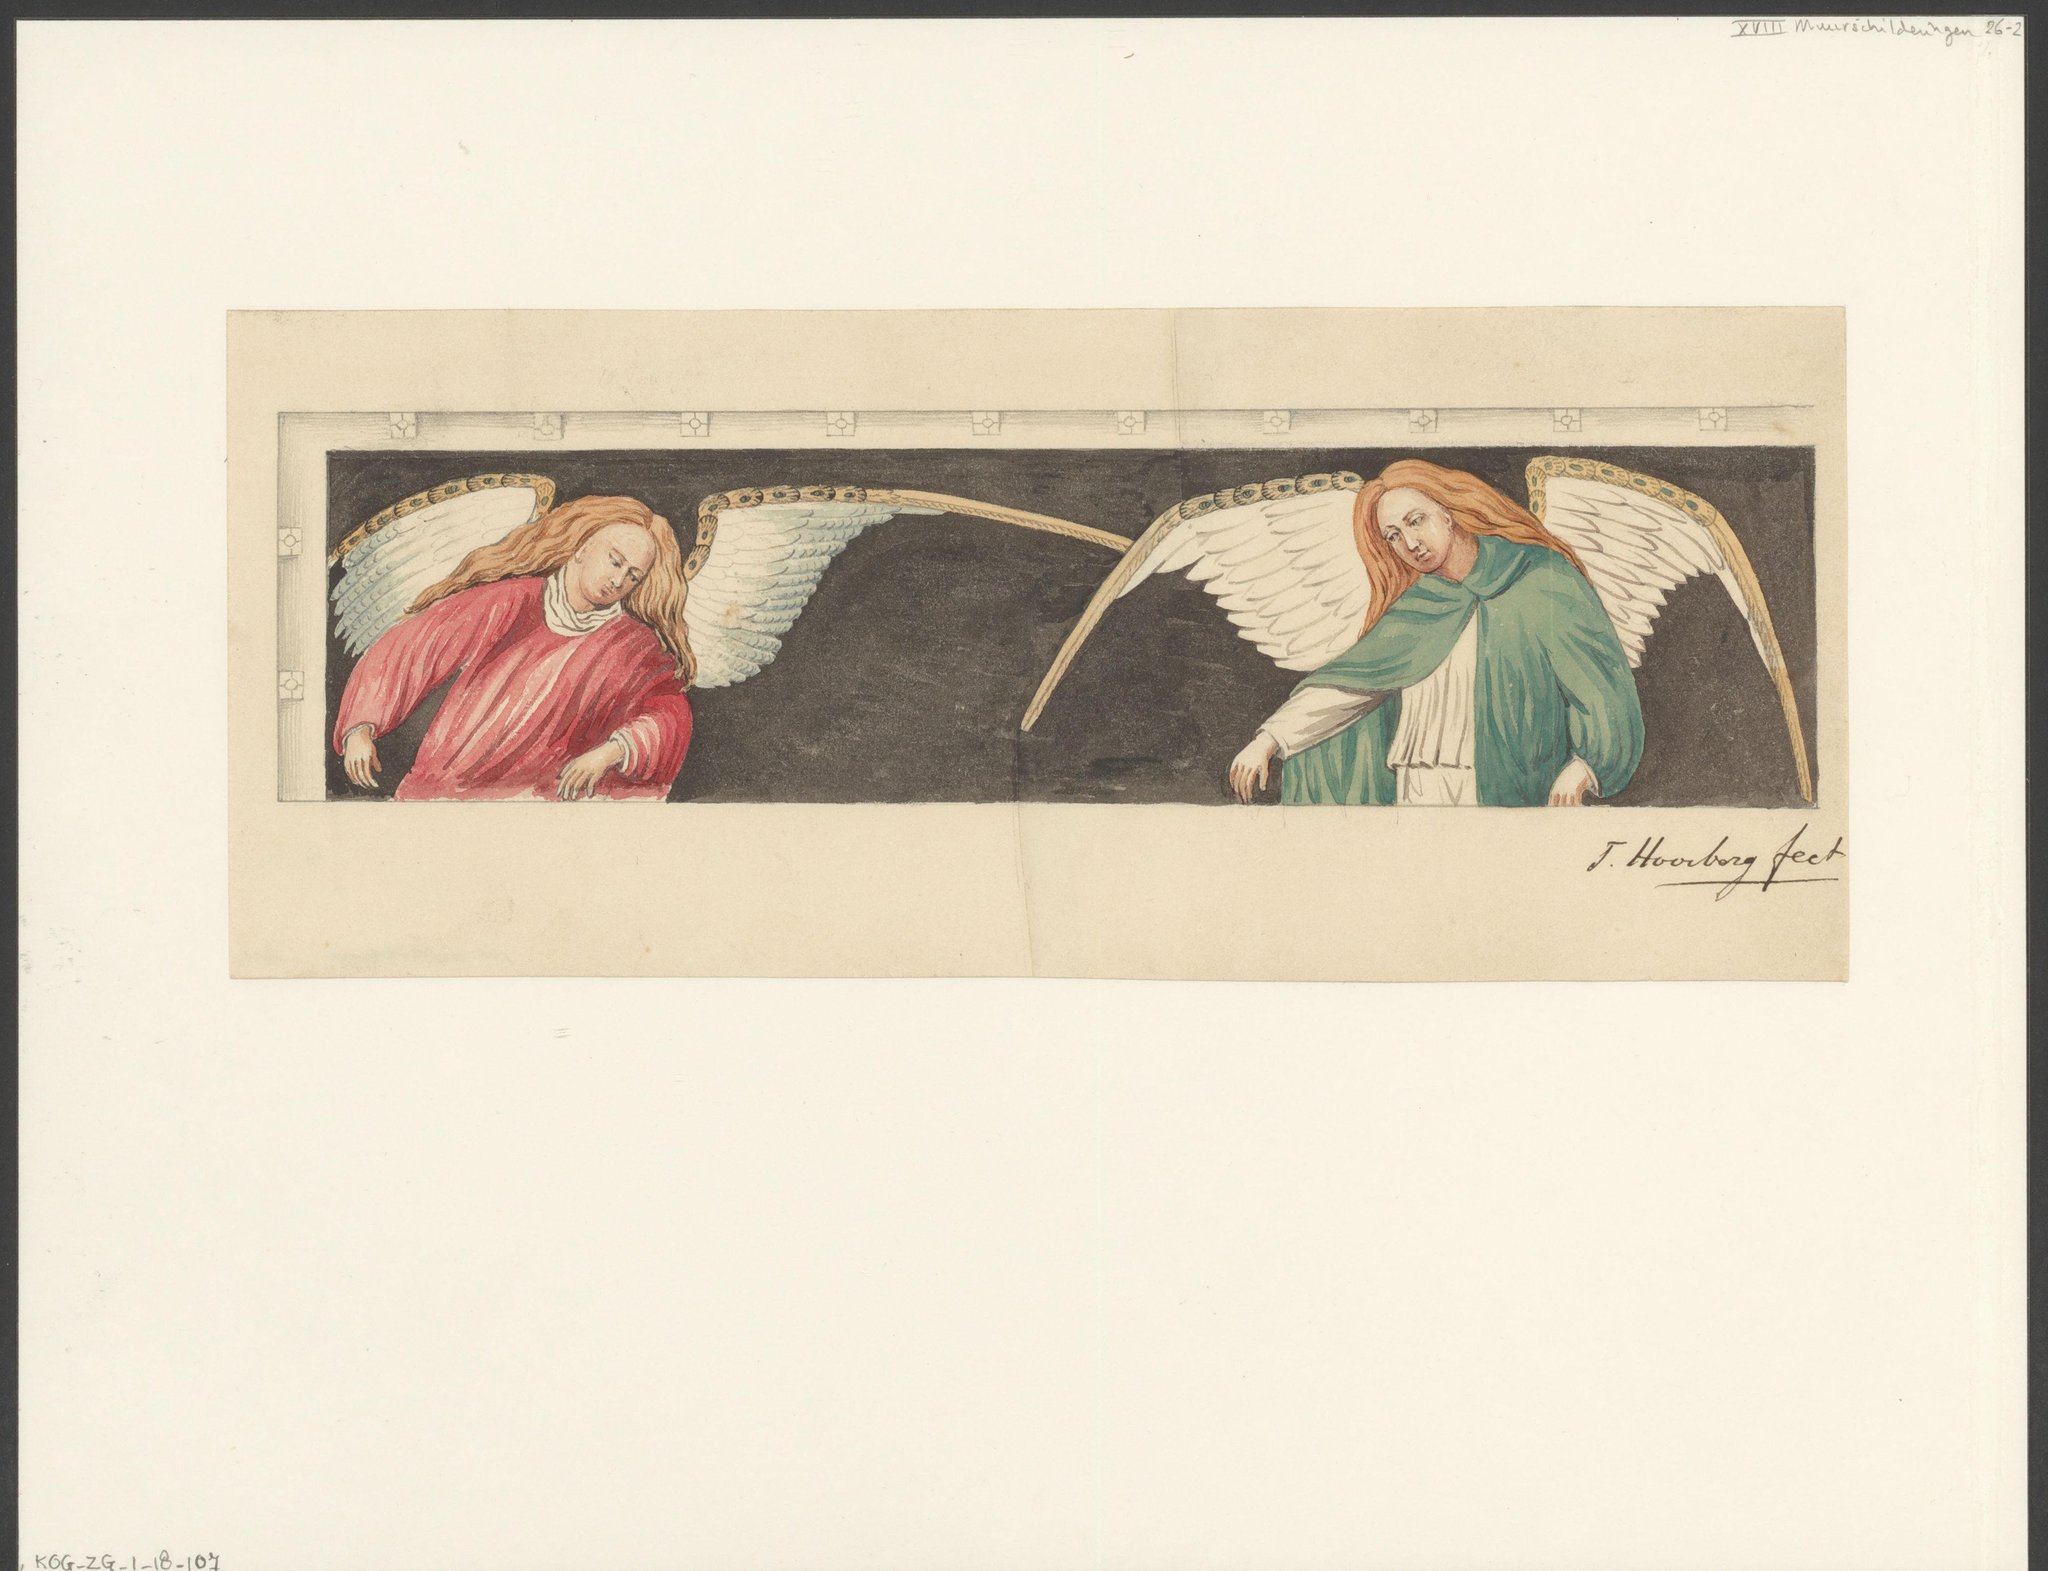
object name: drawing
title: Twee engelen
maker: tiemen hooiberg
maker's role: painter, print maker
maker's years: 1809-1897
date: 1819-1897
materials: ink, paper, pencil, watercolor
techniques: brush, pen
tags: female angels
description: Twee vrouwelijke engelen. Boven en links een ornamentale rand. Onderwerpsrubrieken binnen de Atlas Zeden en Gewoonten: Schoone kunsten, Muur- en gewelfschilderingen.